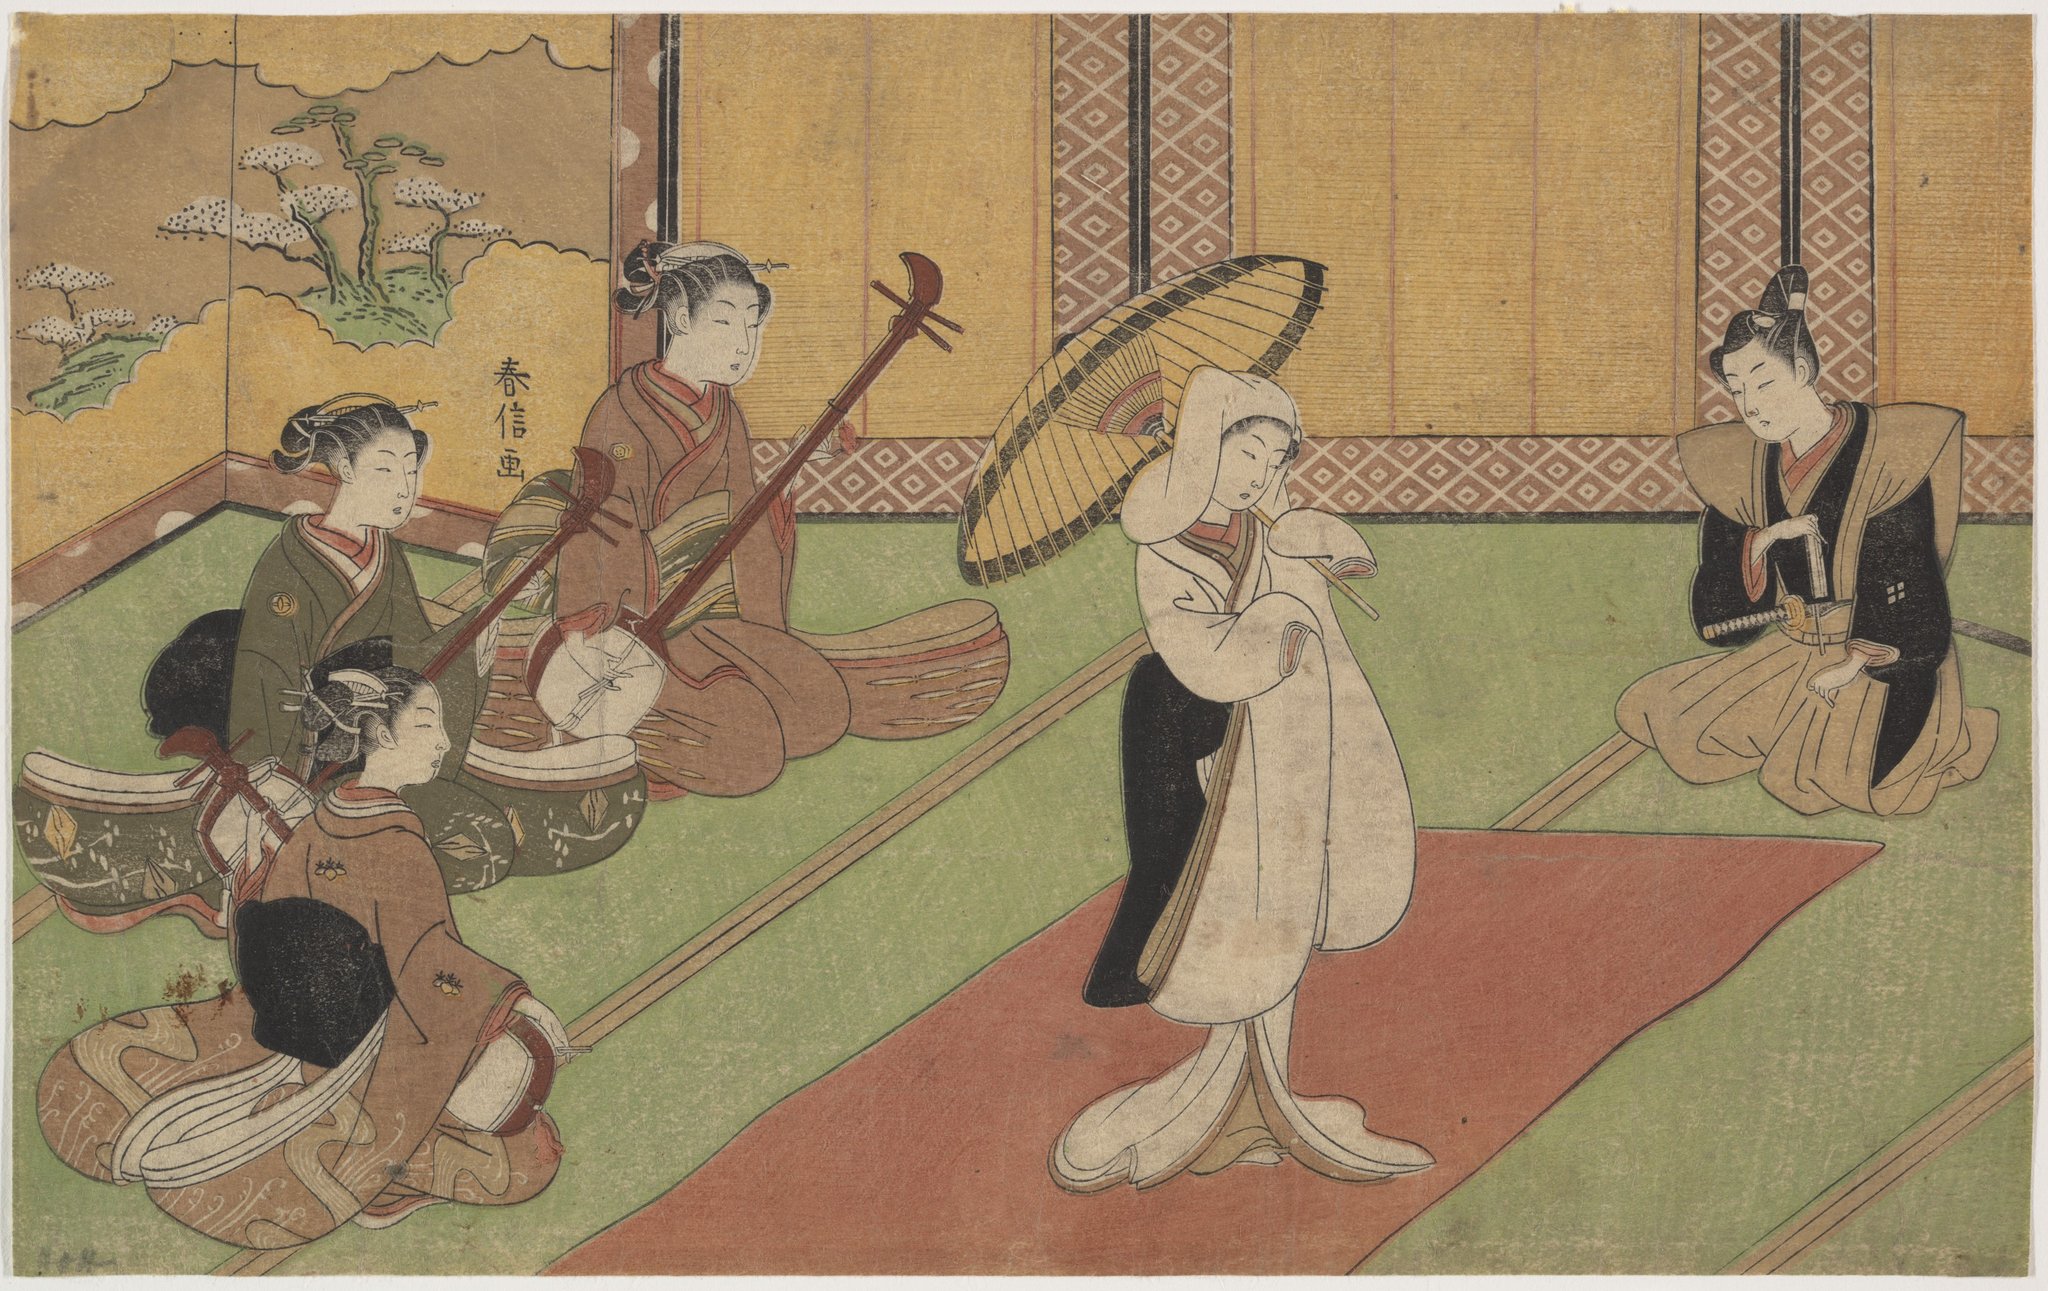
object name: print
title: Woman Dancer in Daimyo's Palace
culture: japanese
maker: suzuki harunobu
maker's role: artist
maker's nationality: japanese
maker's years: 1725-1770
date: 1725-1770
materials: ink, paper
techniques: woodblock print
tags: musical instruments,women,dancers